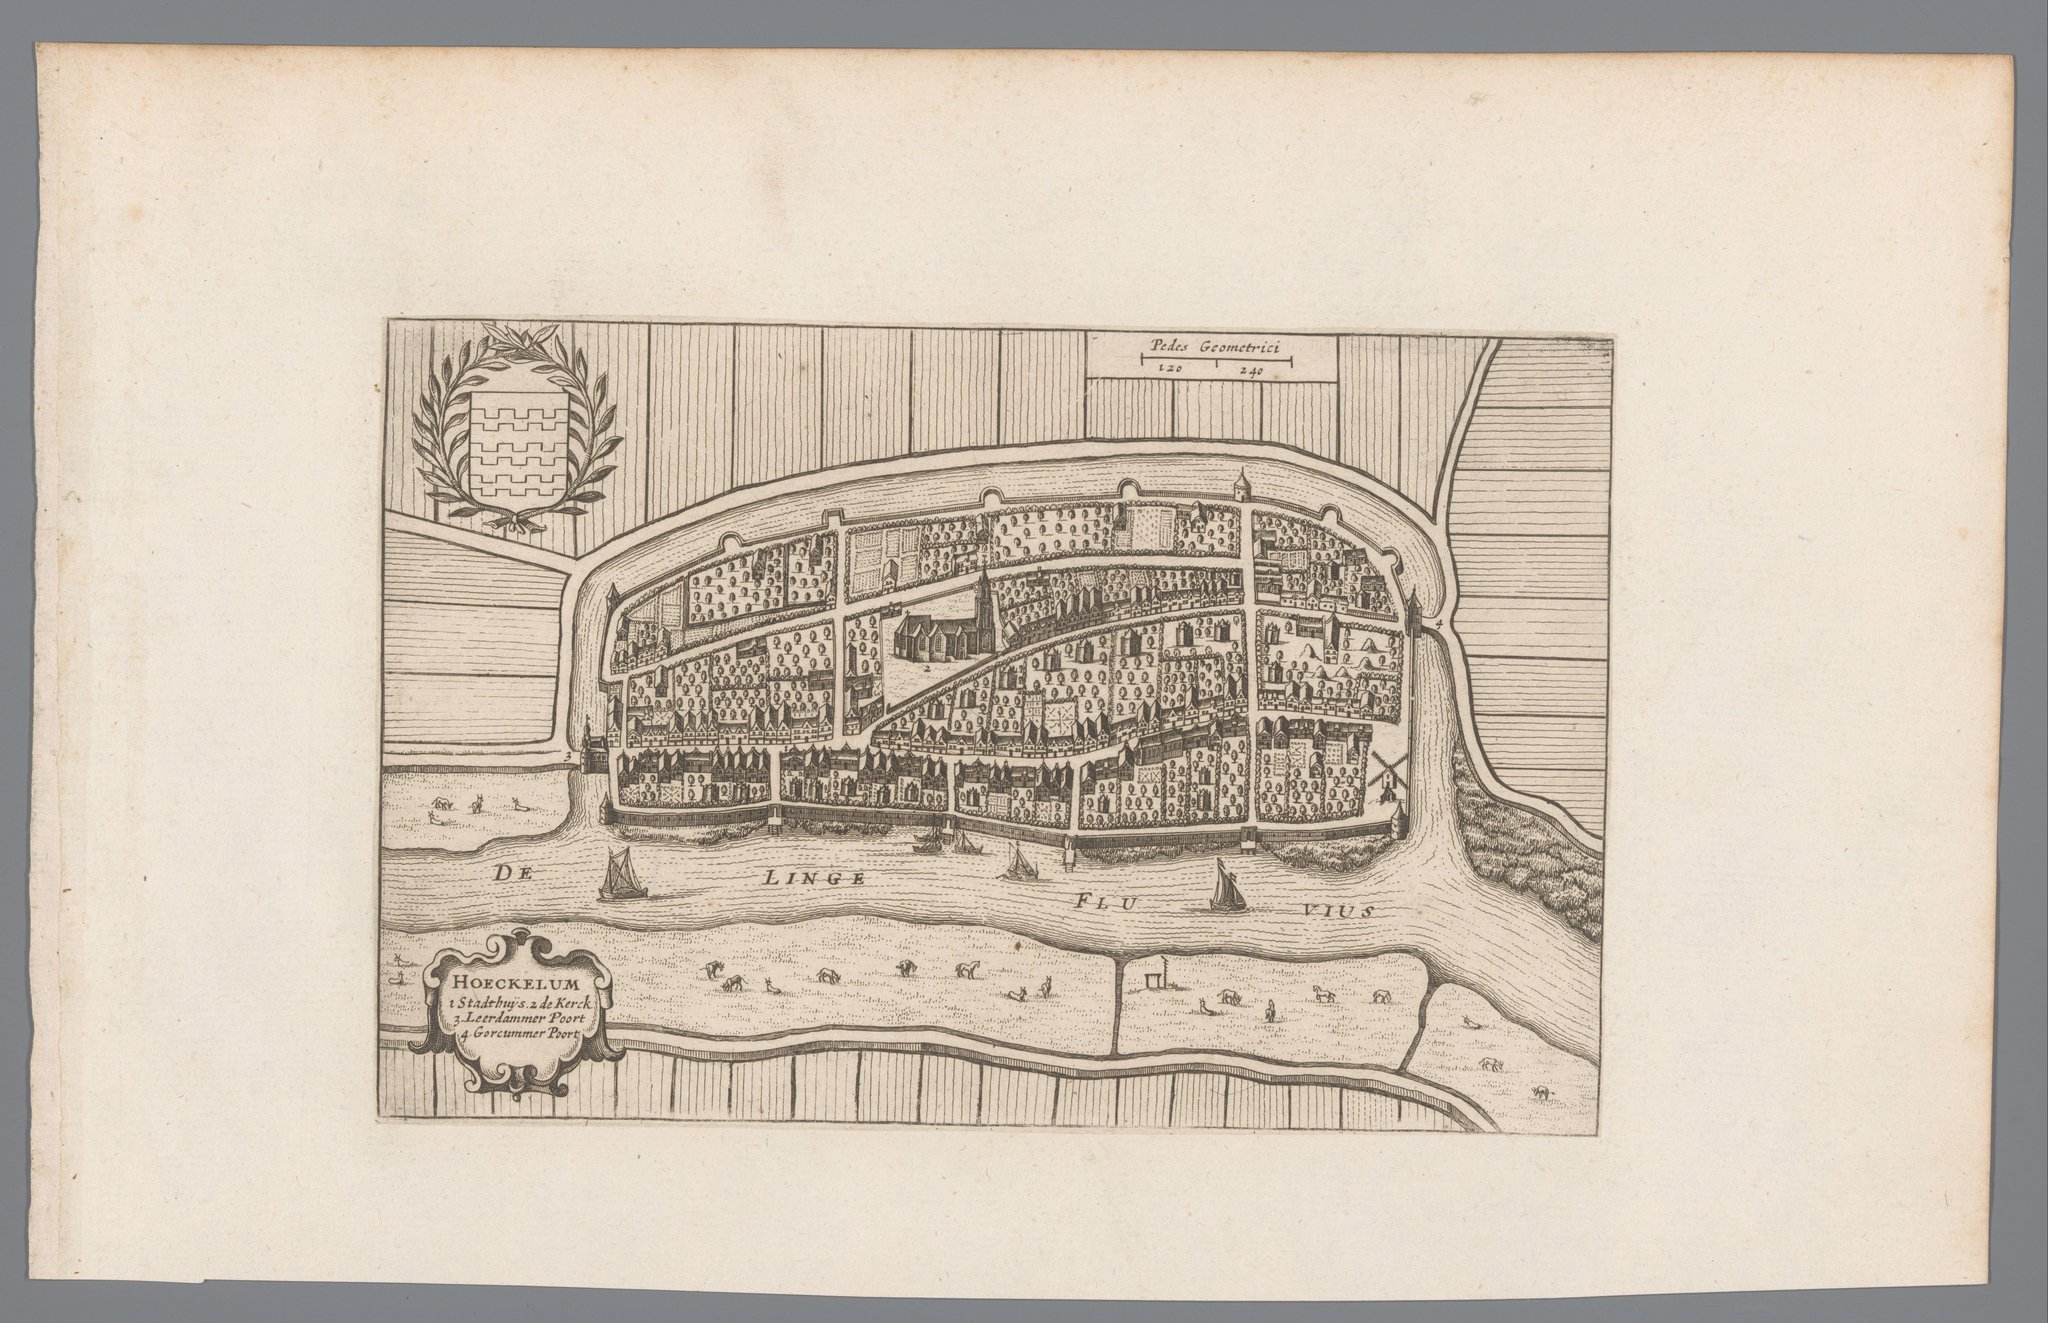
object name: book illustration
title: Plattegrond van Heukelum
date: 1632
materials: paper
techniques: etching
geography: amsterdam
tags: maps of cities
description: Prent uit: Boxhorn, Marcus Zuerius. Theatrum sive Hollandiae comitatus et urbium nova descriptio (...). Amsterdam: Henricus Hondius, 1632, p. 324.